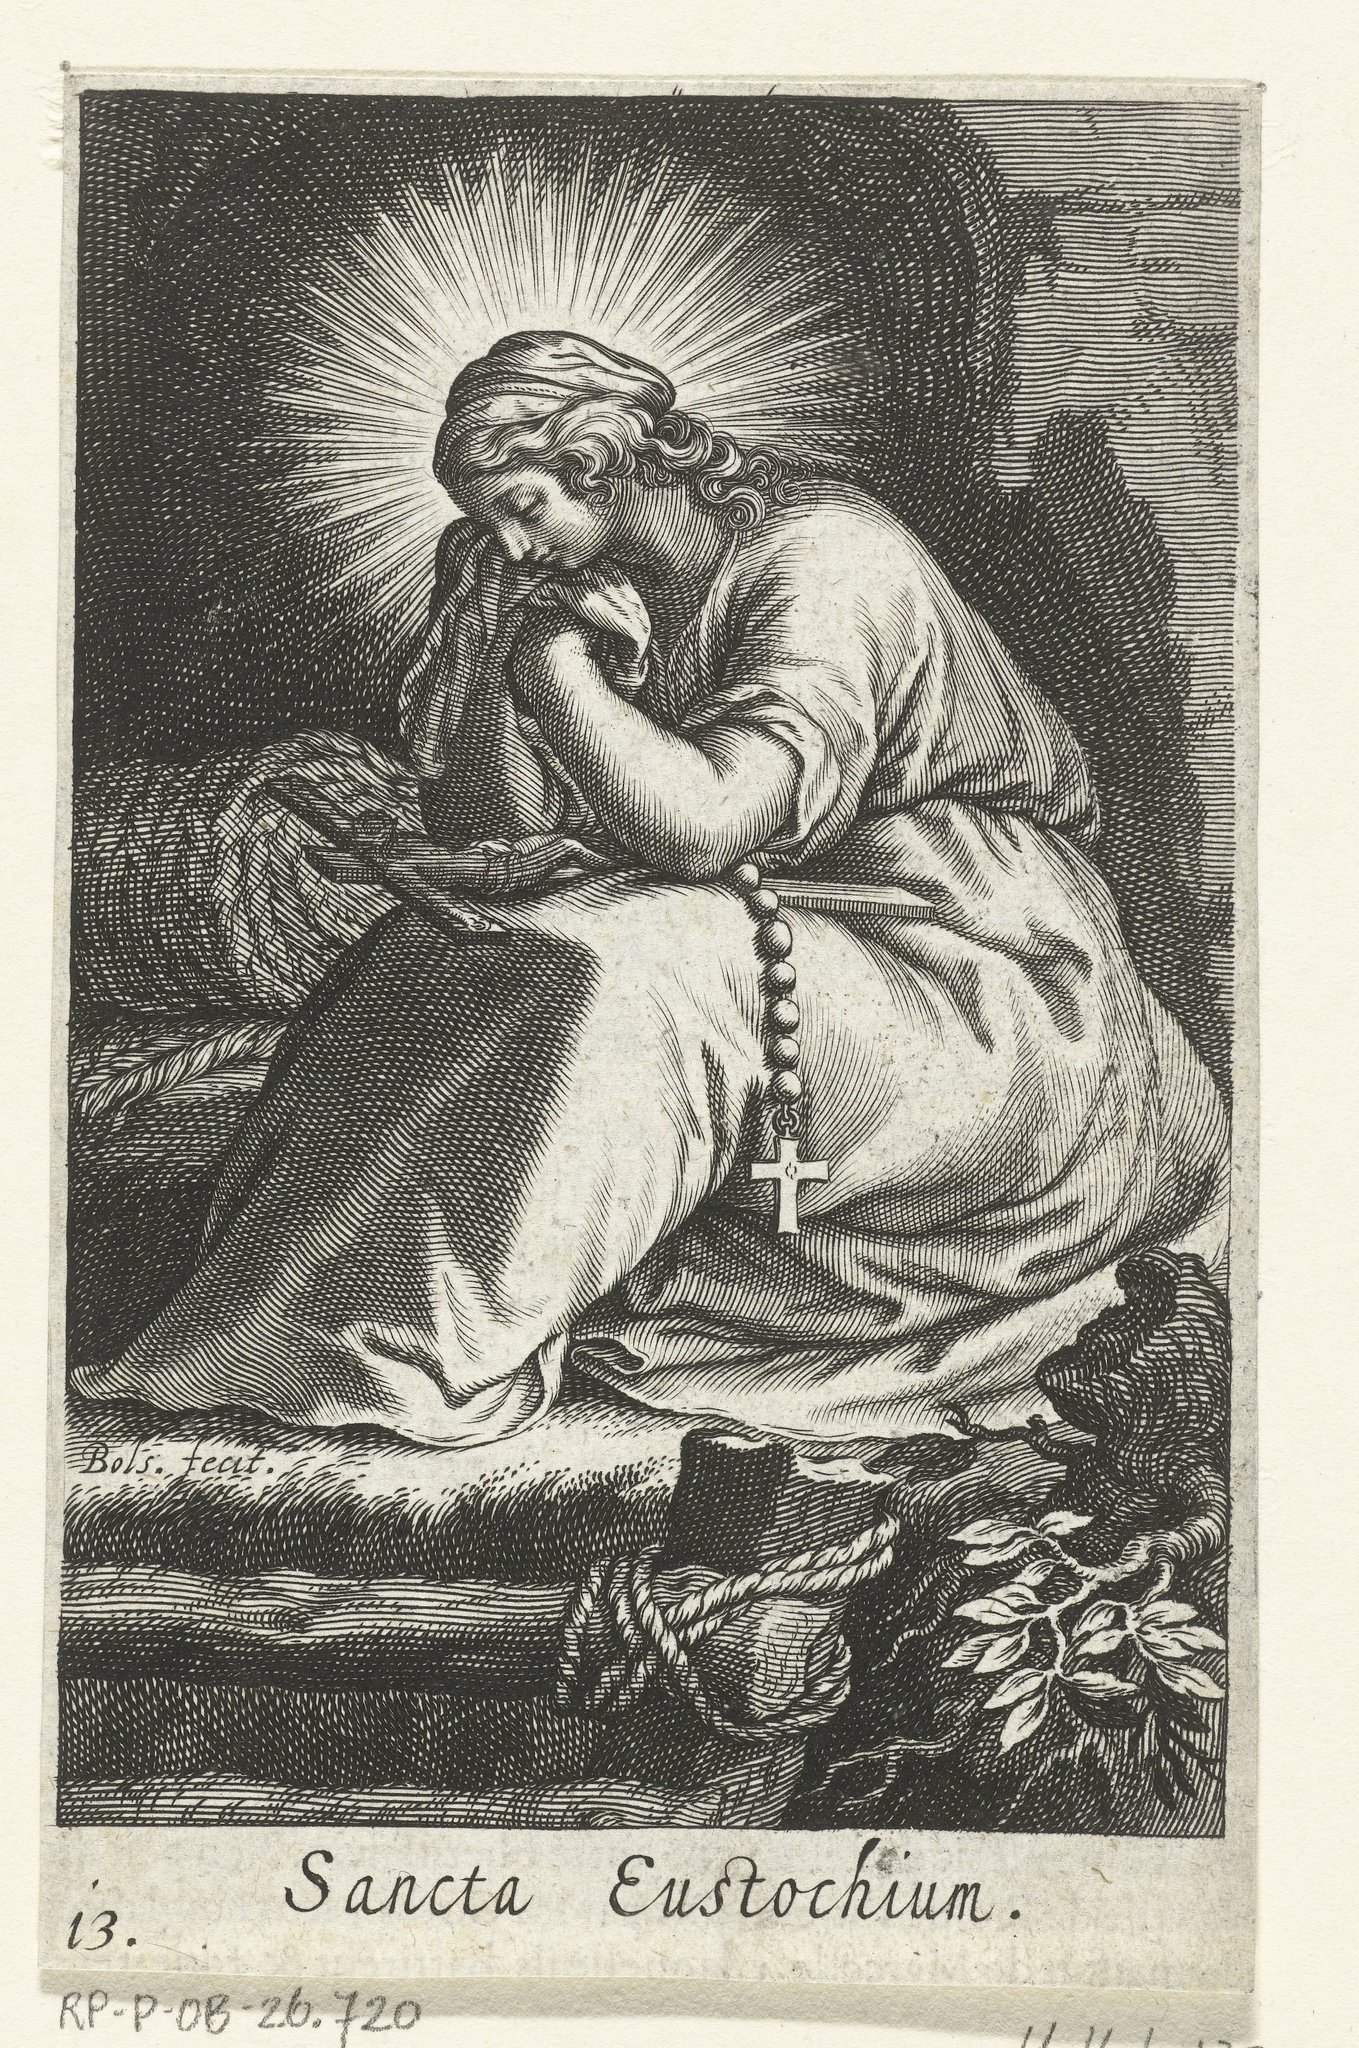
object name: book illustration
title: Sacra Eremus Ascetriarum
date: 1590-1612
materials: paper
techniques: engraving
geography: amsterdam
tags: anchorite, hermit, female saints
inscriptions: collector's mark: Lugt 2228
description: Prent uit: Sacra Eremus Ascetriarum, Hendrik Aertssen, Antwerpen 1619. Prent uit de serie van vijfentwintig kluizenaressen in deze uitgave. In 1612 verscheen de ongebonden editie maar op basis van de gewijzigde opschriften en samenstelling van de serie kluizenaars wordt aangenomen dat de prenten van de uitgave 1619 ook in 1612 of iets daarvoor gedrukt werden. De serie kluizenaressen bleef vrijwel ongewijzigd in de ongebonden uitgave van 1612, dit compliceert de datering van de losse bladen in de collectie van het RMA, zie Roethlisberger 1993, p. 171-175. Door de aanwezigheid van Franse tekst op het verso kunnen we vaststellen dat dit blad afkomstig is uit de Antwerpse uitgave van 1619.